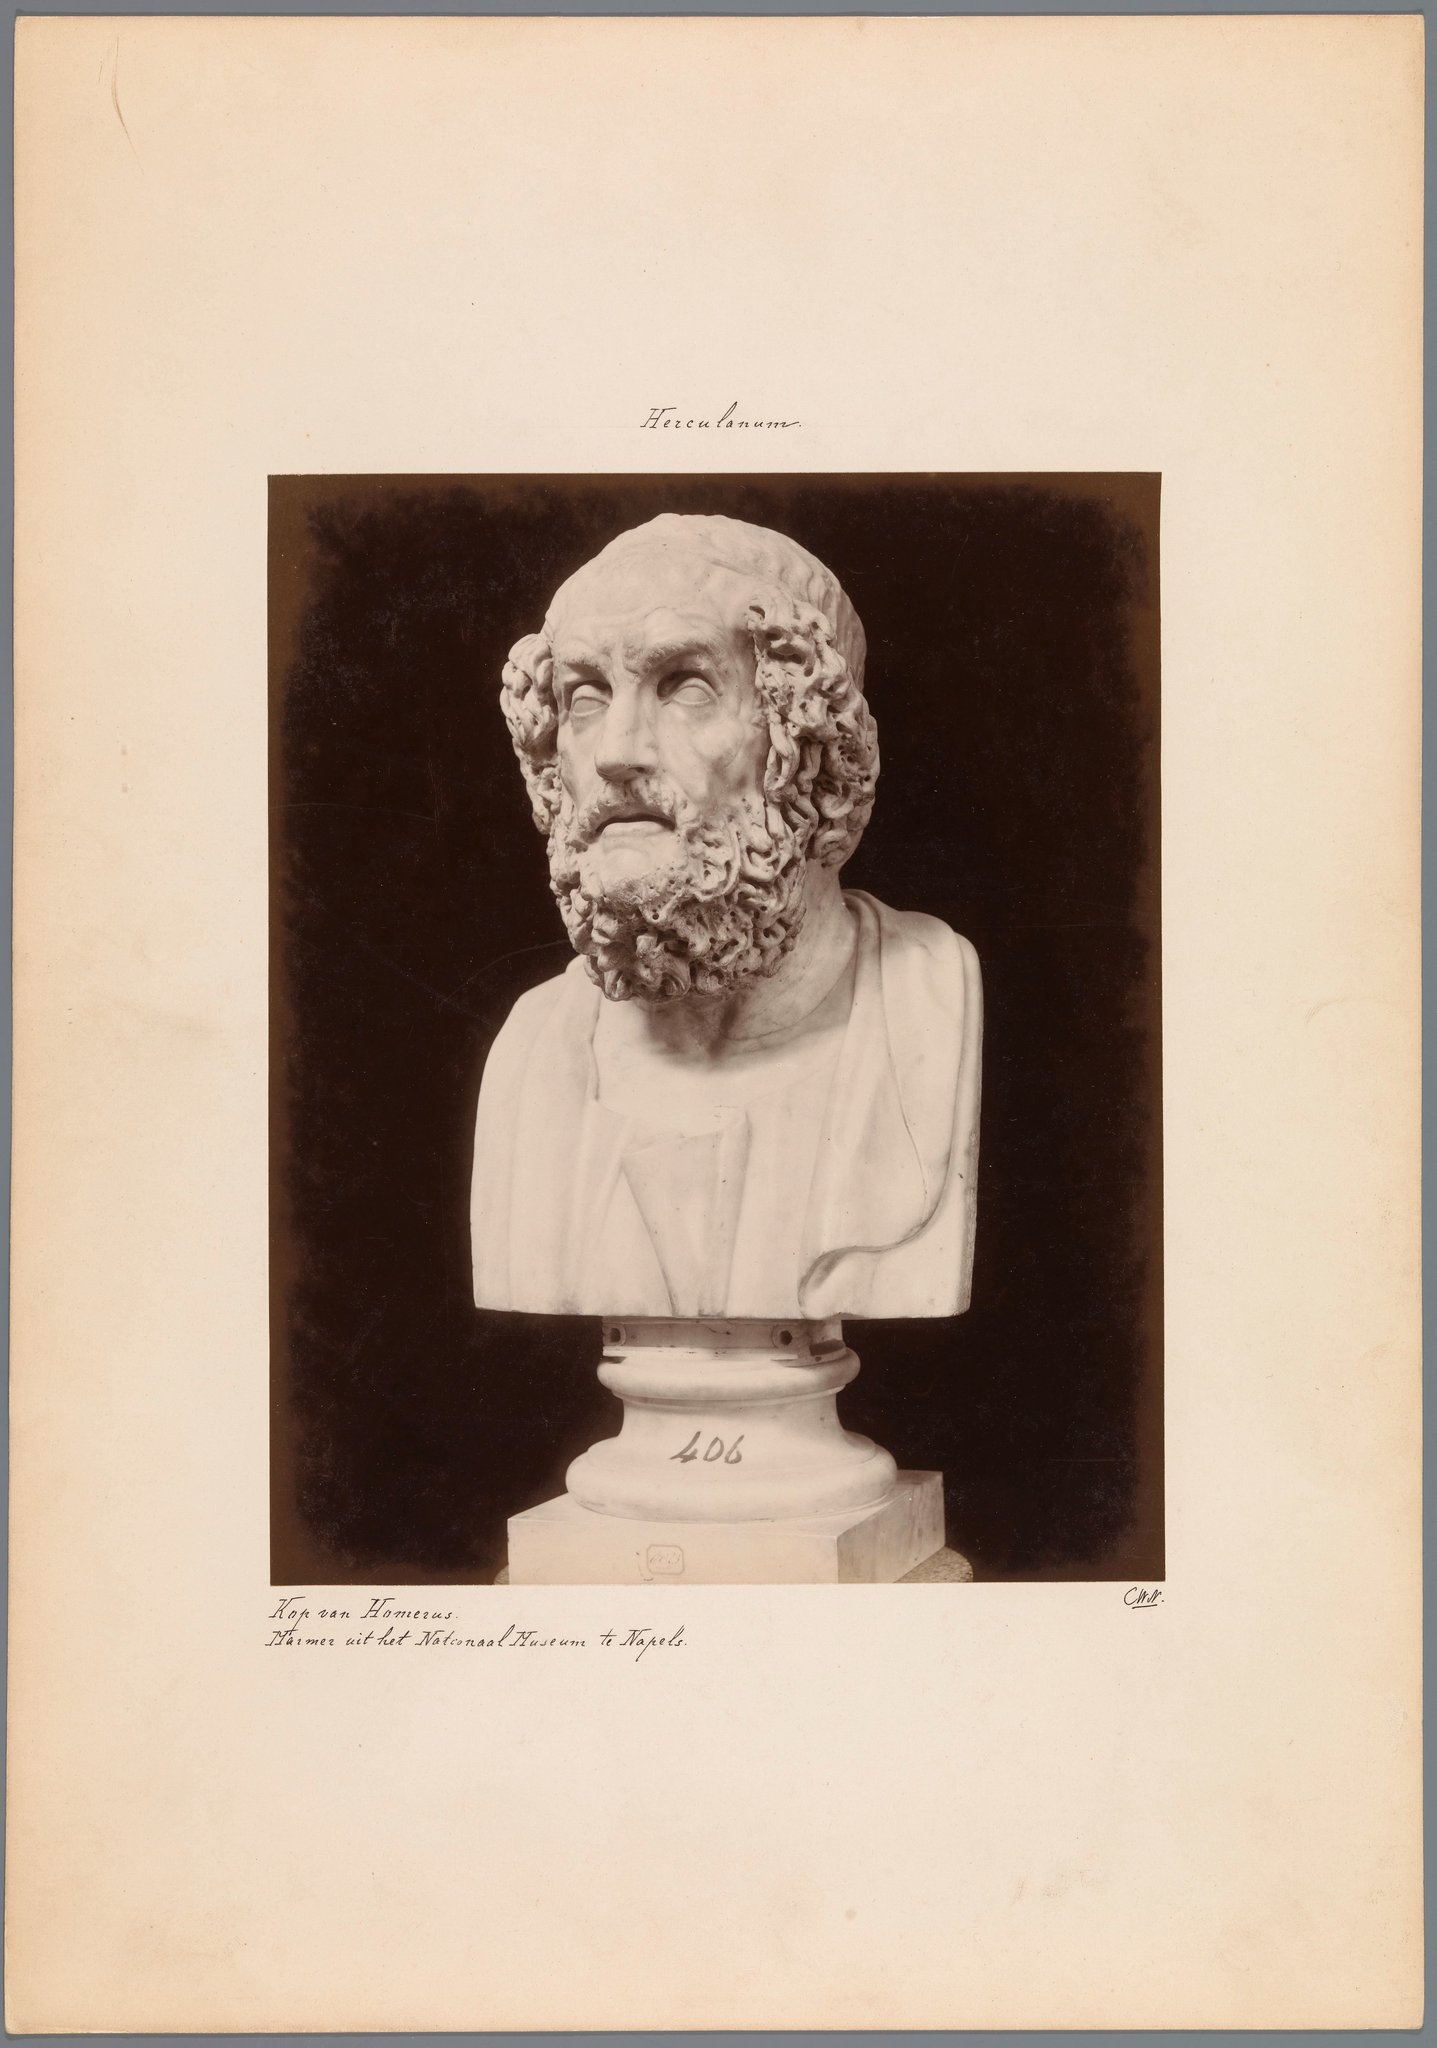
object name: photograph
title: Buste van Homerus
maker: Anonymous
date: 1875-1900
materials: cardboard, photographic support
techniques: albumen print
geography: europe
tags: male persons from classical history (+ head, bust, etc.), piece of sculpture, reproduction of a piece of sculpture, portrait of homer, europe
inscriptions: inscription: ‘CWN.’, collector's mark: ‘INSTITUUT VOOR KUNST-NIJVERHEIDSONDERWIJS GABRIËL METSUSTRAAT No. 16 AMSTERDAM’, inscription: ‘Herculanum.’, collector's mark: ‘KUNSTNIJVERHEIDSCHOOL QUELLINUS AMSTERDAM FRANS HALSSTRAAT 14.’